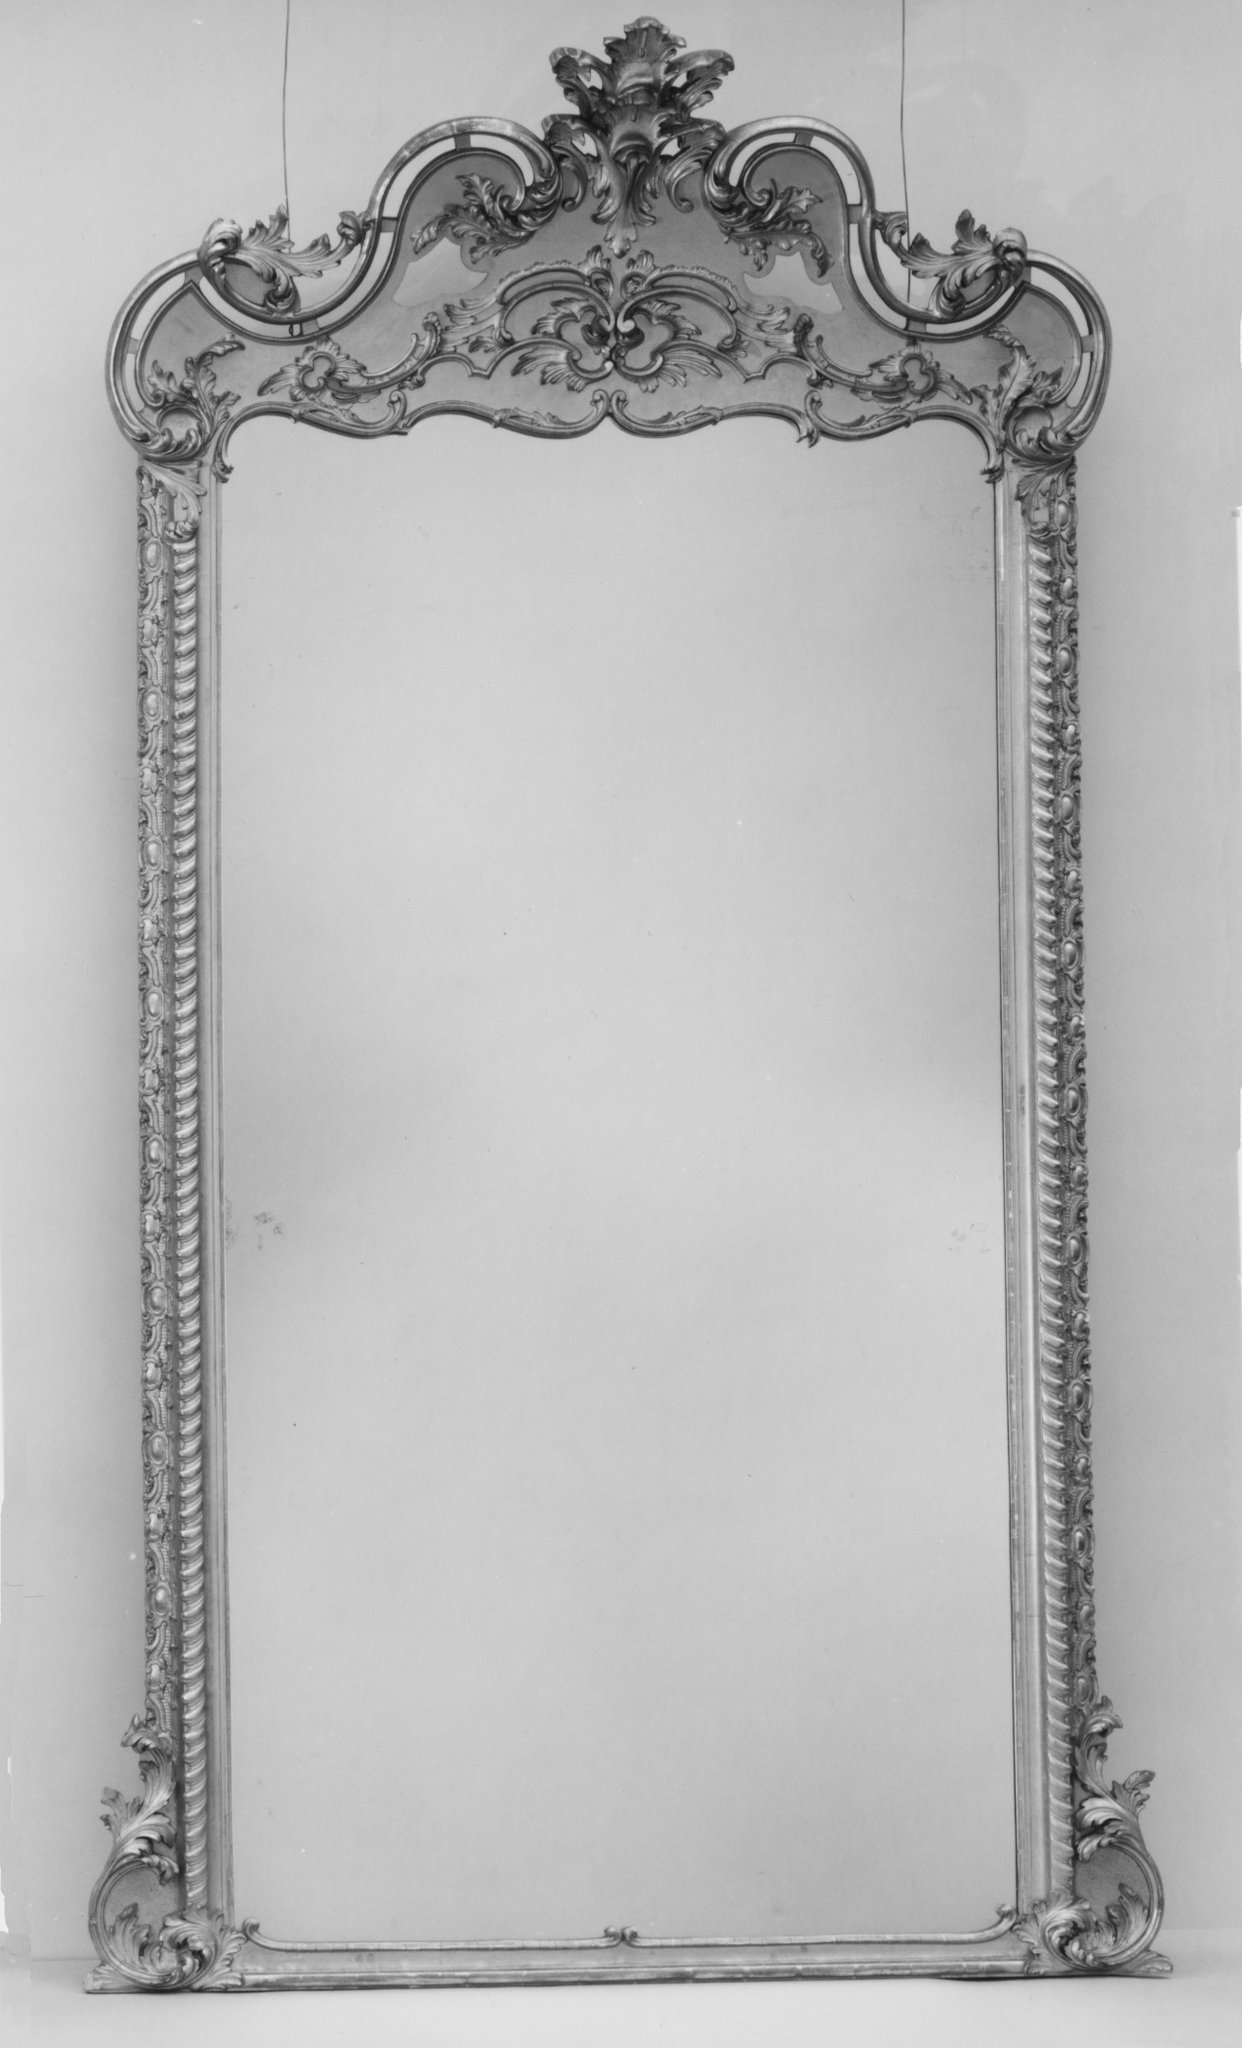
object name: pier glass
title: Pier Looking Glass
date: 1853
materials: iron, gesso, gilt, glass, marble, wood